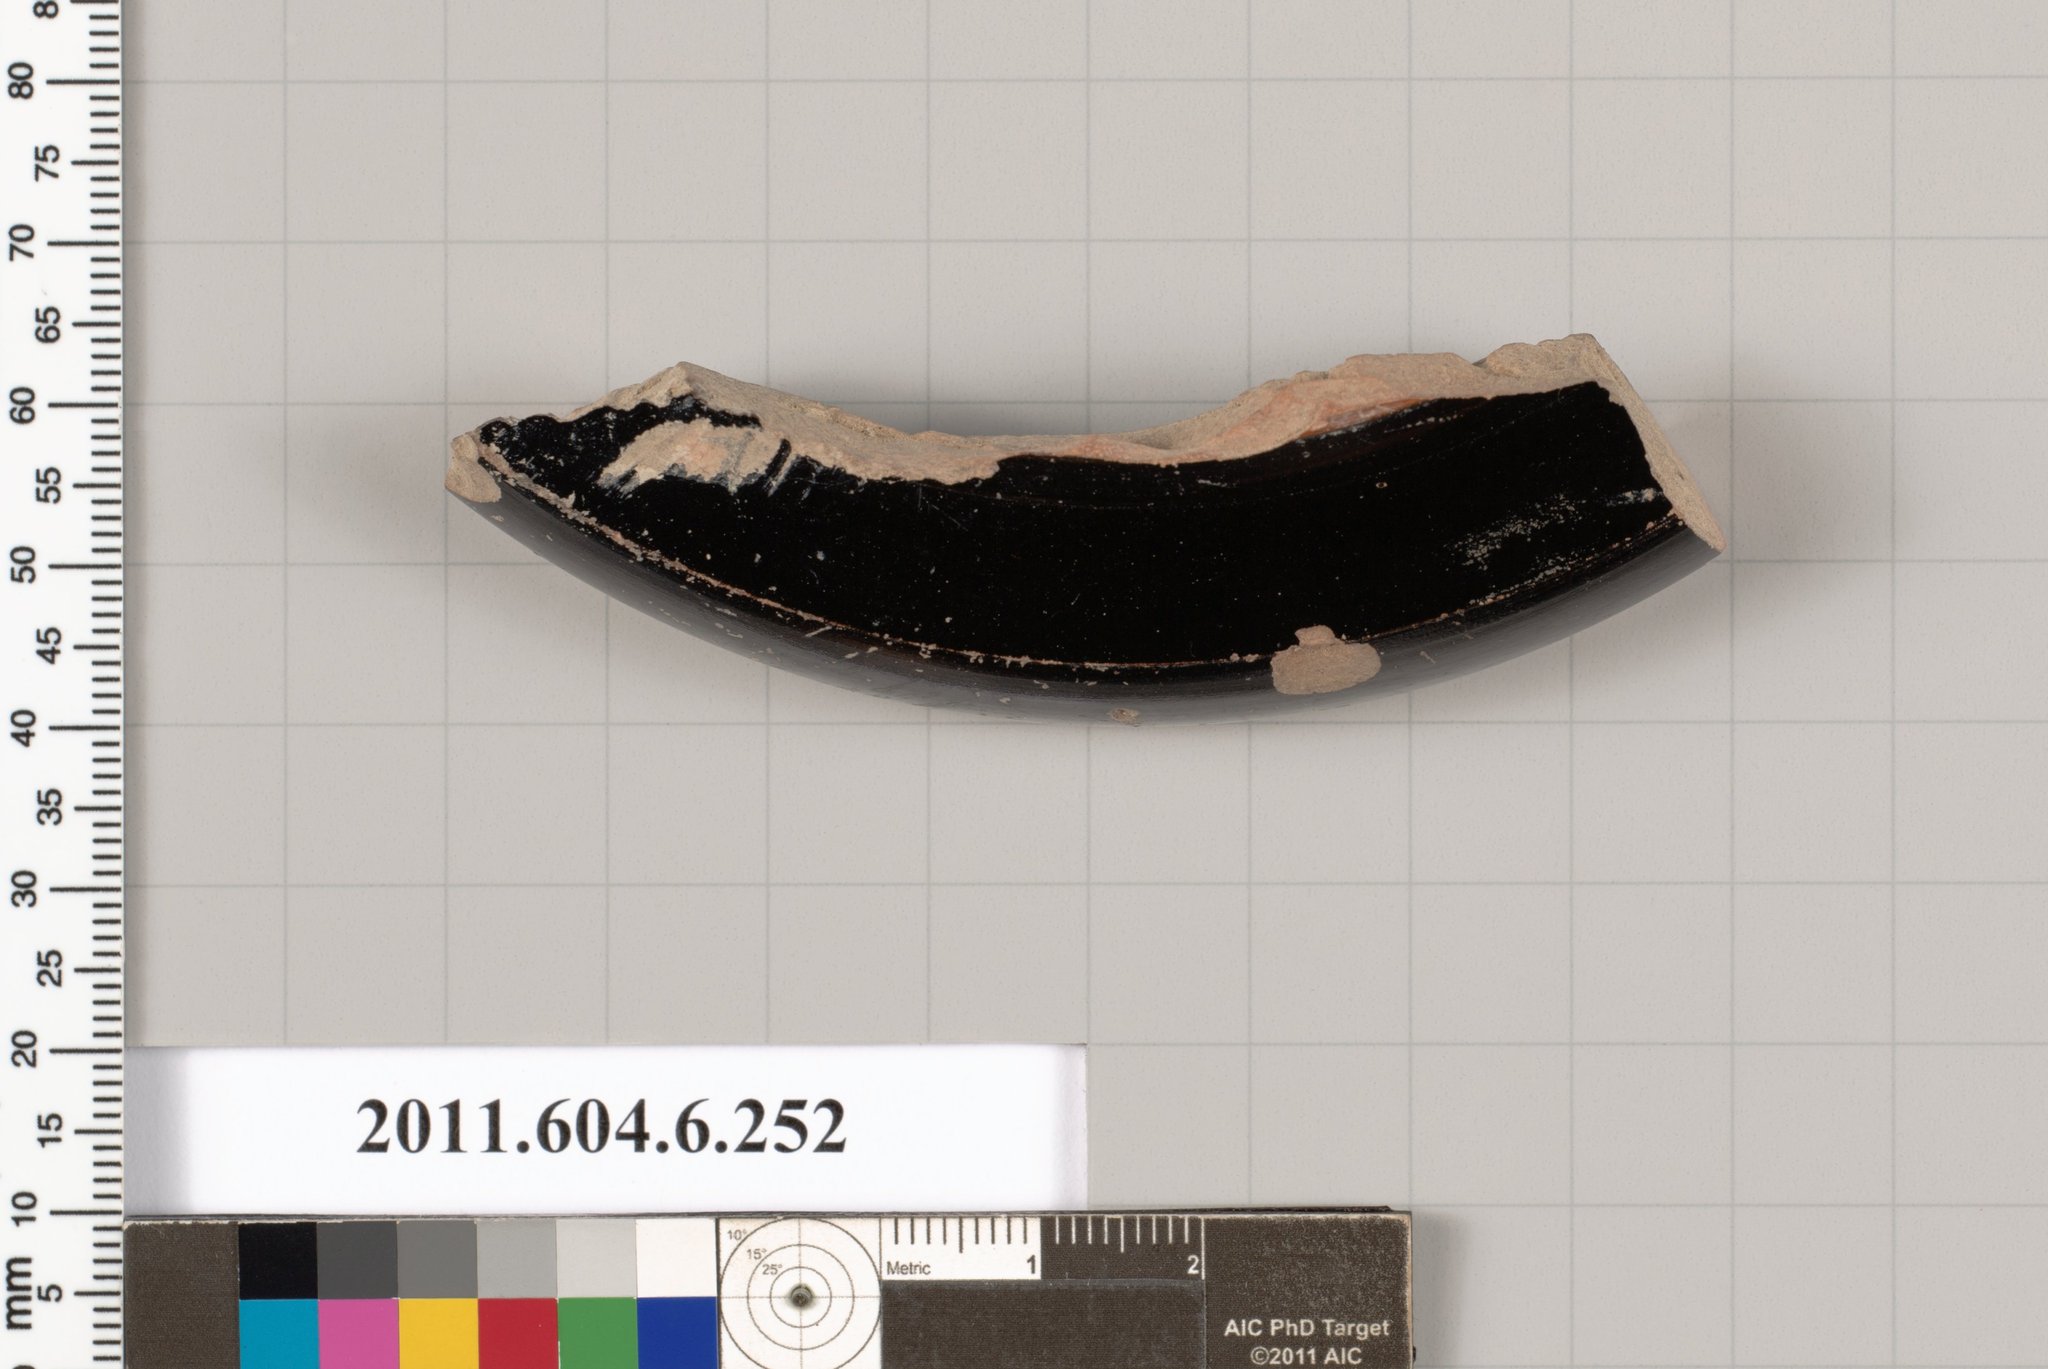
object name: undetermined shape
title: Terracotta fragment of an undetermined shape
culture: greek, attic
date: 500-301 BCE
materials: terracotta